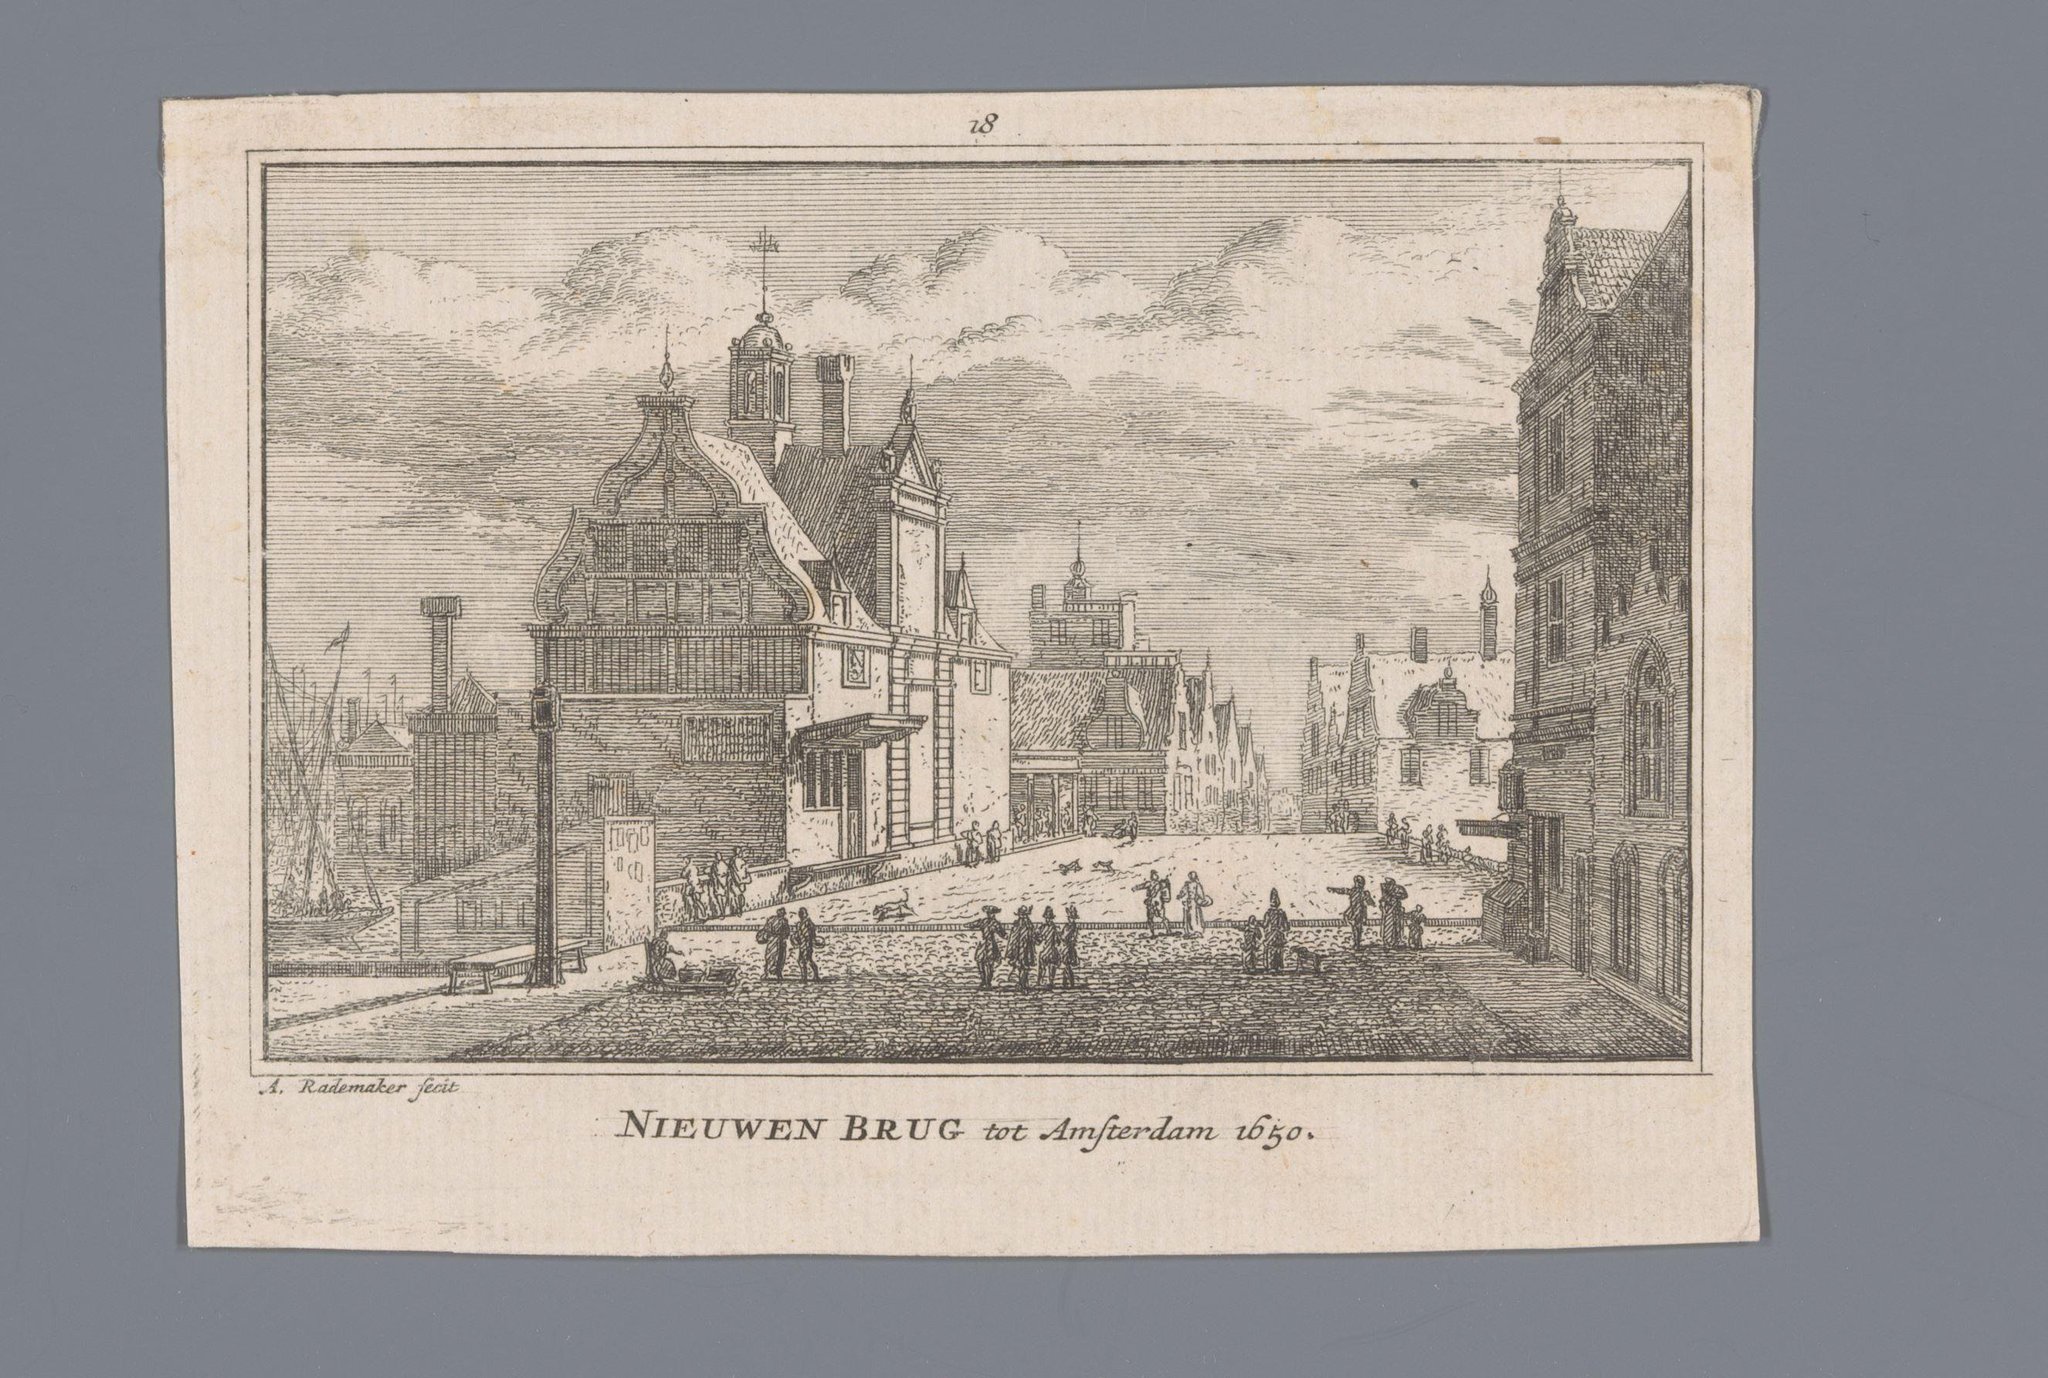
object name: book illustration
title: Nieuwen brug tot Amsterdam 1650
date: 1725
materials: paper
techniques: engraving, etching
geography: amsterdam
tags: prospect of city, town panorama, silhouette of city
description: Prent uit: Rademaker, Abraham. Kabinet van Nederlandsche outheden en gezichten (...). Amsterdam: Willem Barents, 1725, plaat 18.